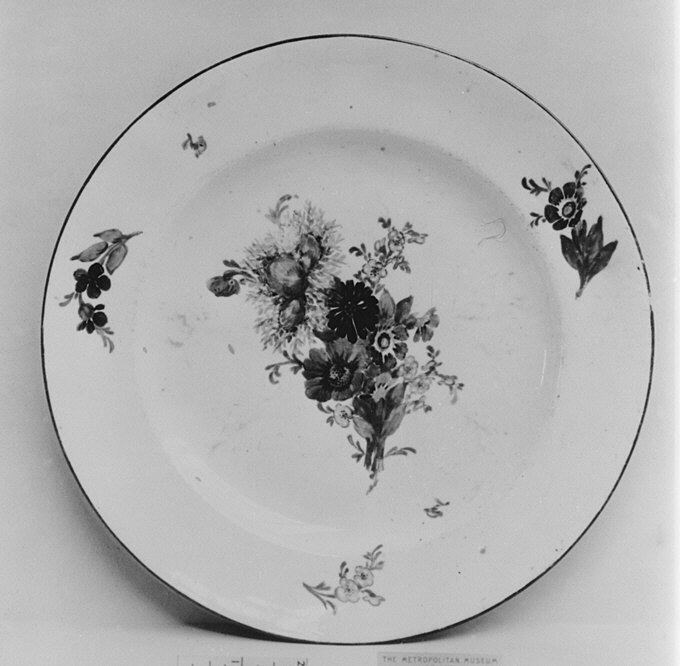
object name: plate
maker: imperial porcelain manufactory, st. petersburg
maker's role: manufactory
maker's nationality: russian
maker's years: 1744-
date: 1796-1801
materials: hard paste porcelain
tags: flowers